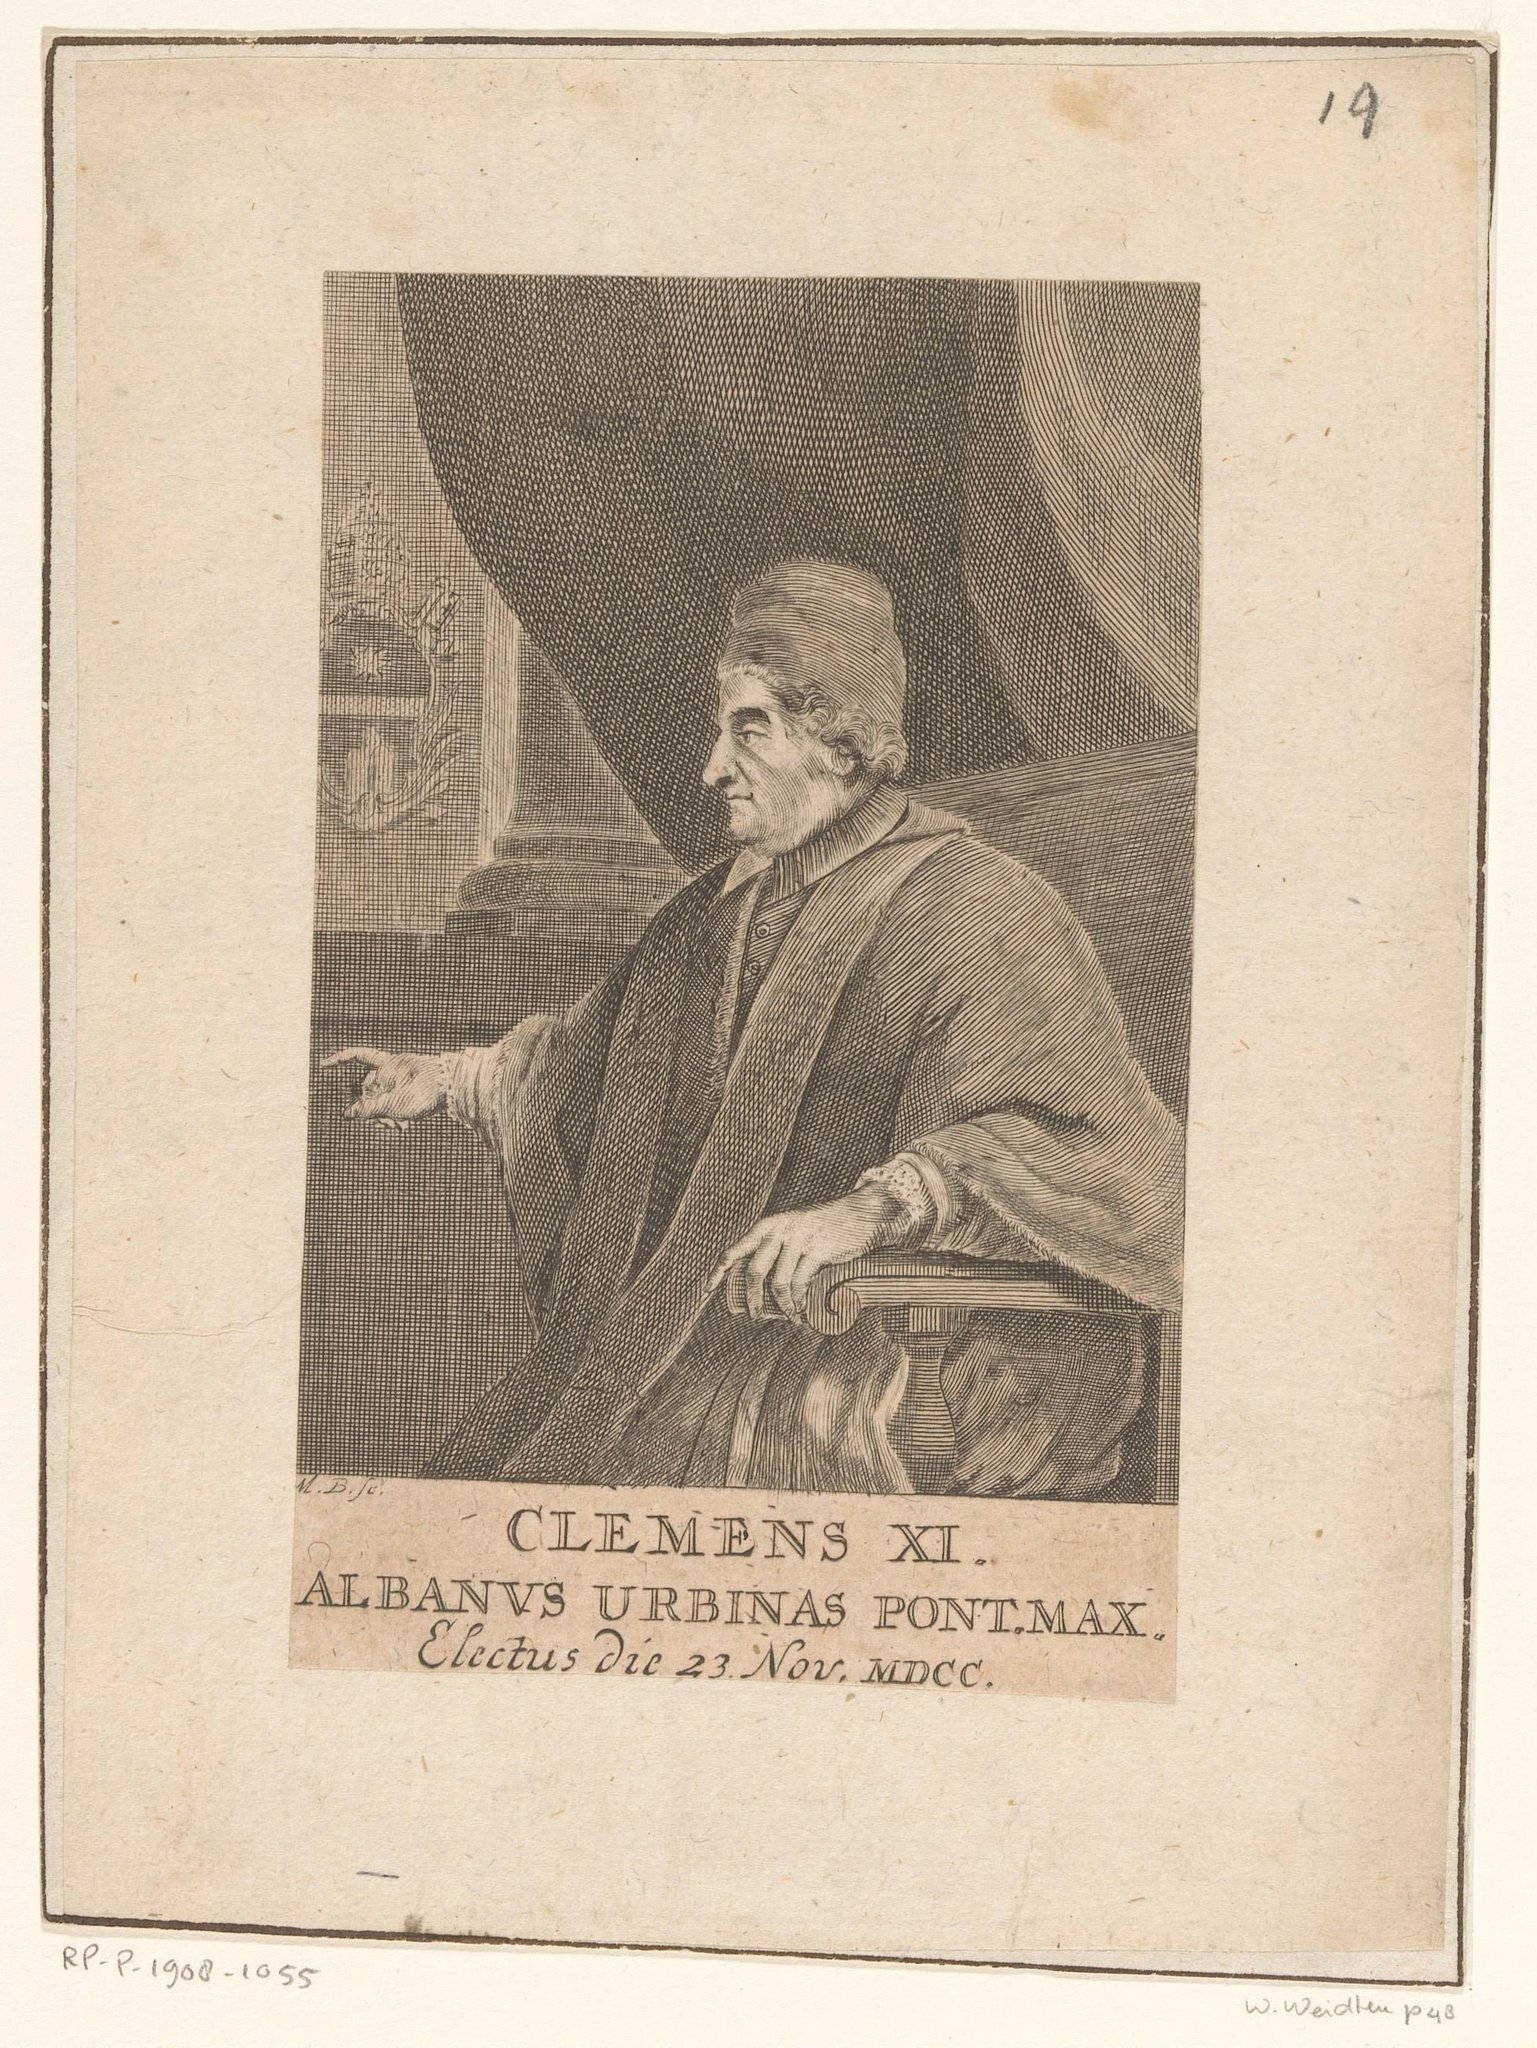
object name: print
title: Portret van paus Clemens XI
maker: martin bernigeroth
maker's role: print maker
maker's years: 1670-1733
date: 1700-1733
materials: paper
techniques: engraving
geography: leipzig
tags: rome, clergyman, clemens xi, historical persons, armorial bearing, heraldry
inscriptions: collector's mark: Lugt 2228